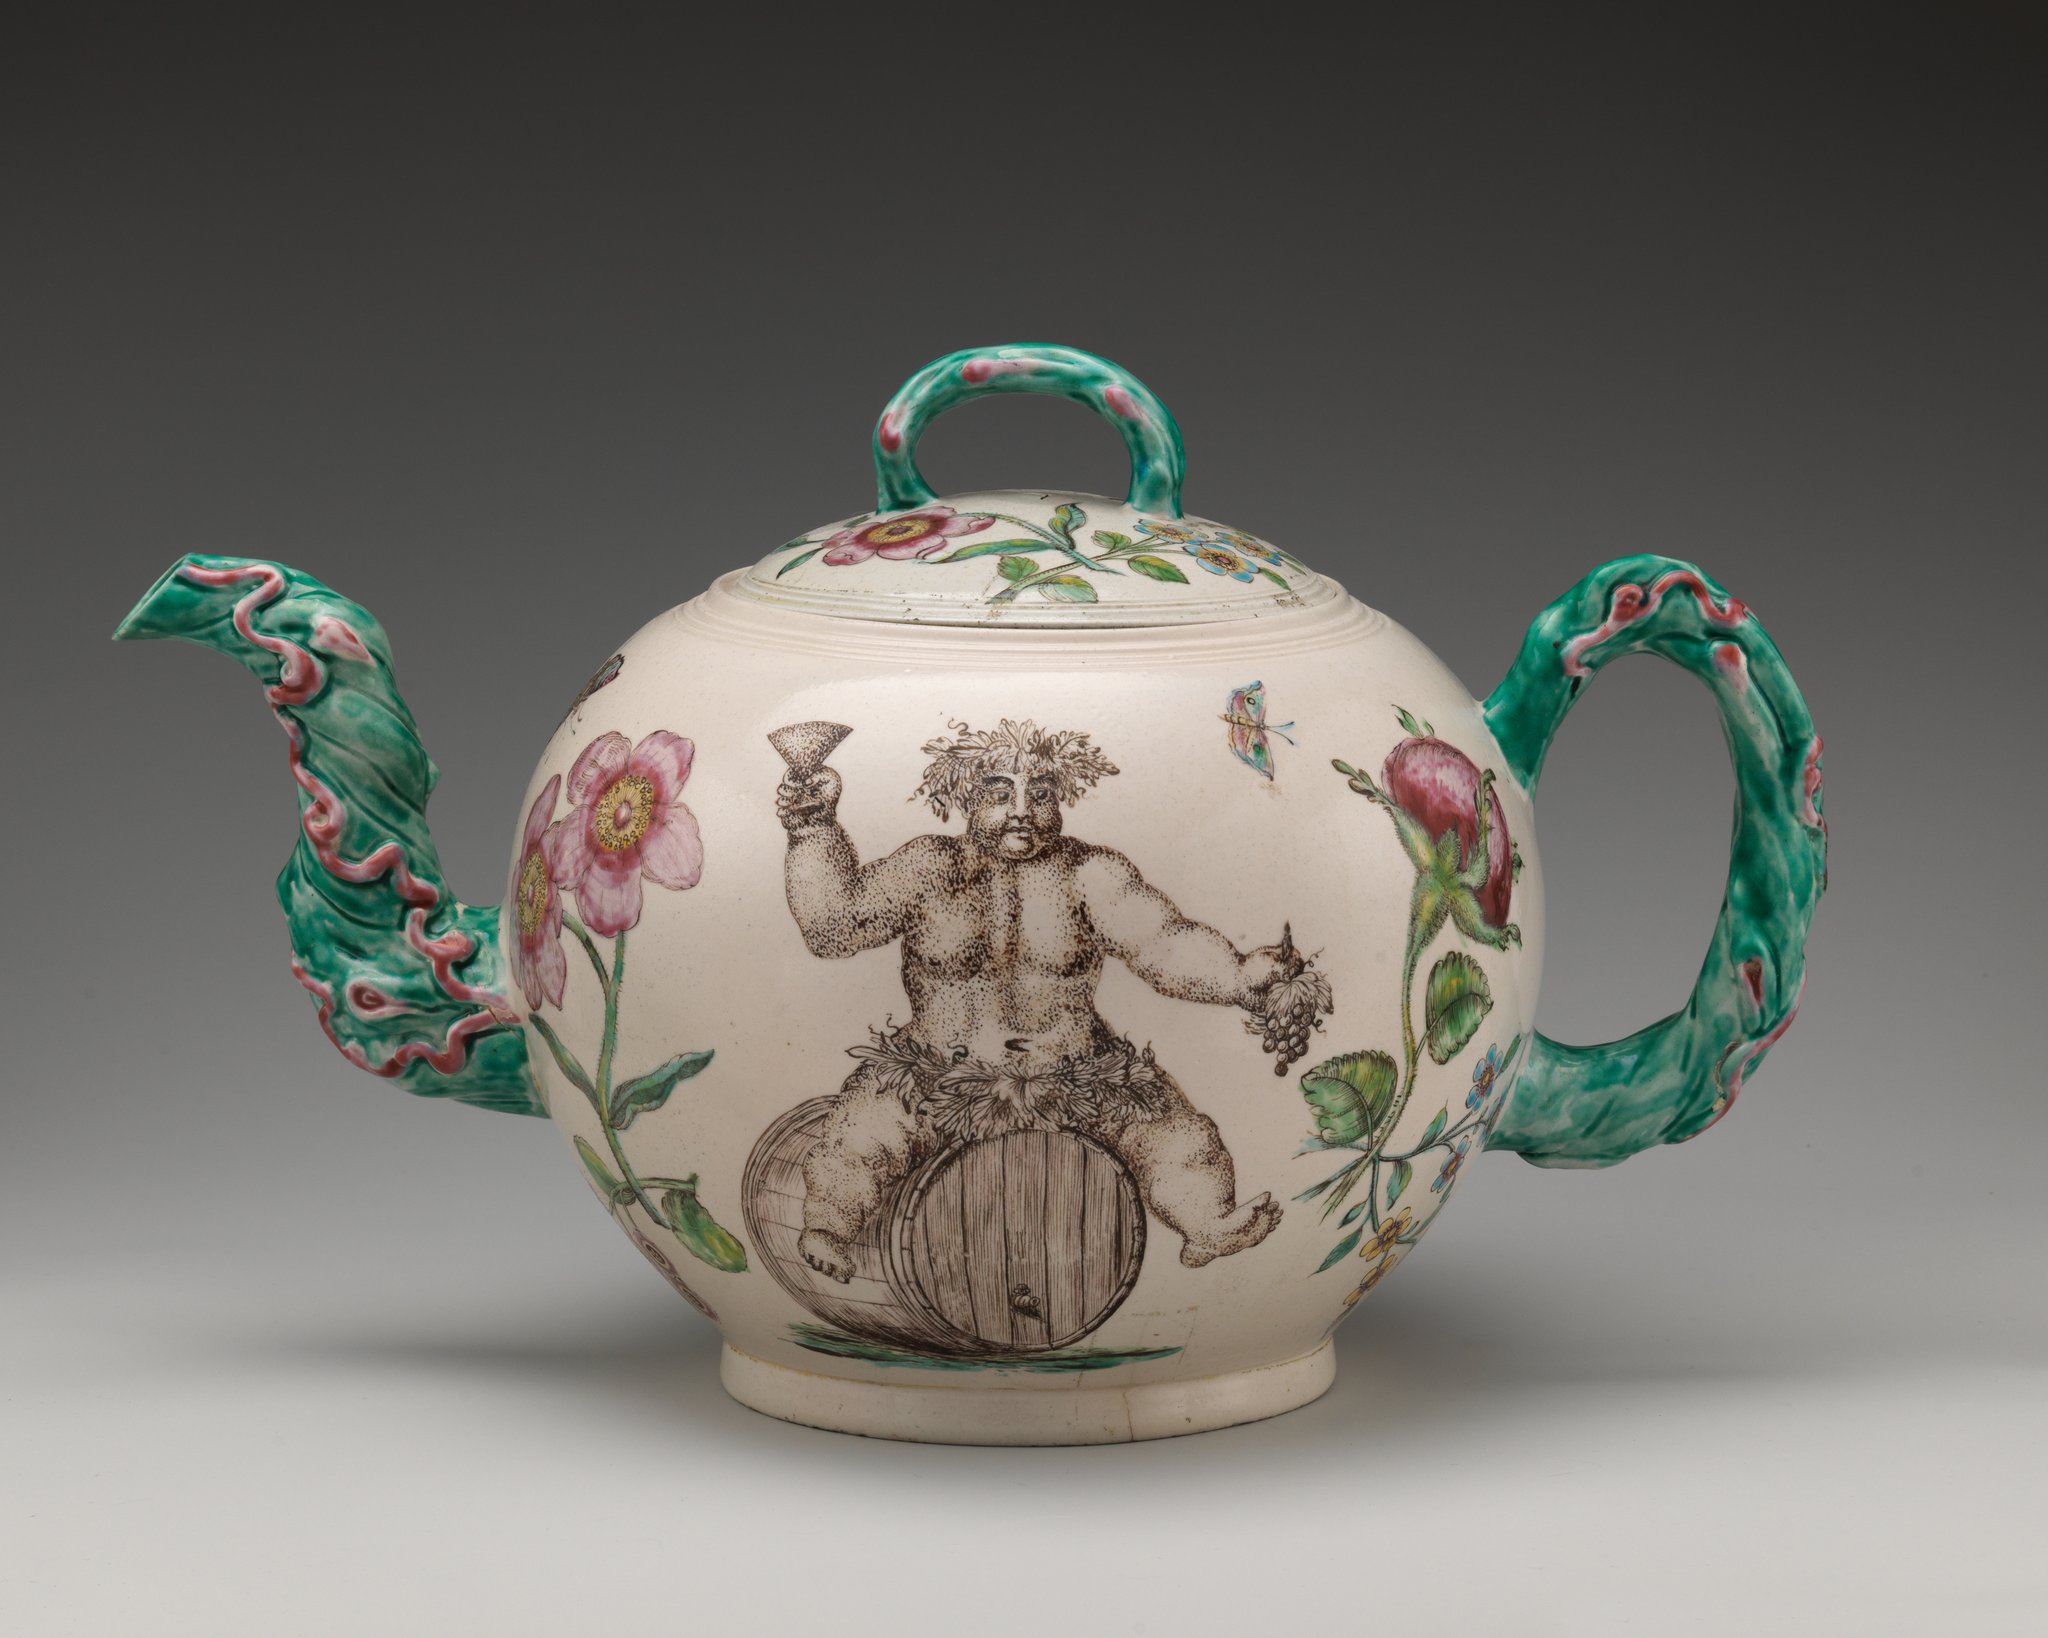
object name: punch pot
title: Punch pot with Bacchus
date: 1760-1765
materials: enamel, stoneware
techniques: salt glaze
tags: human figures